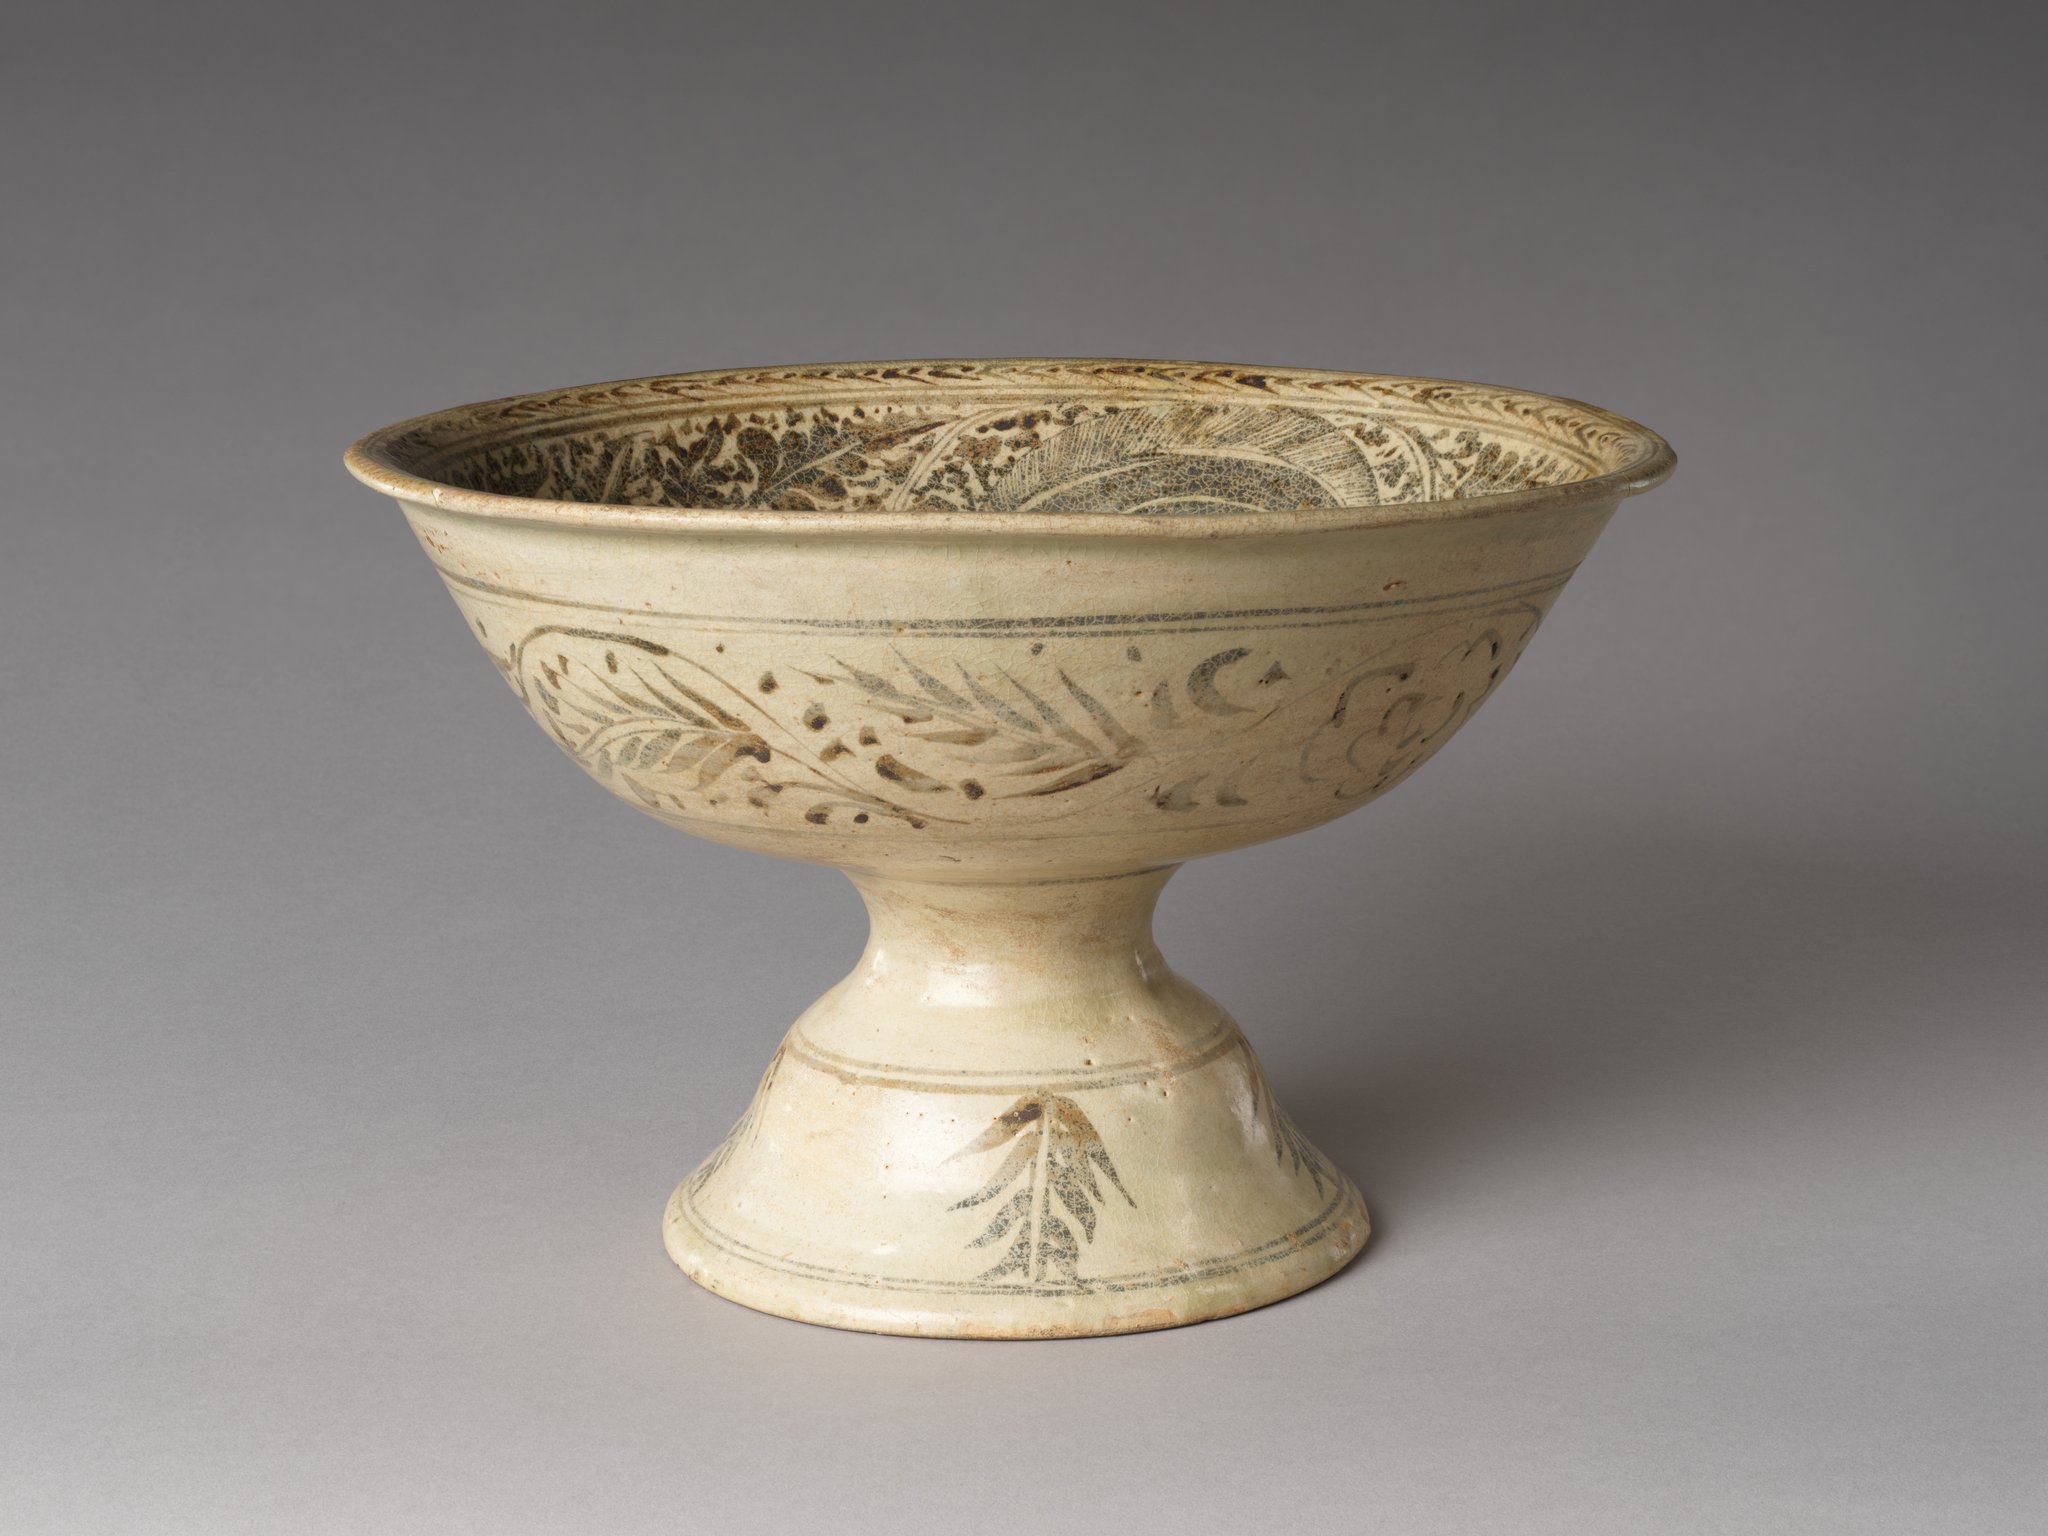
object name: pedestal dish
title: Pedestal dish with catfish and aquatic plants décor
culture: thai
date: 1401-1500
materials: iron, stoneware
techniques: painting, underglaze